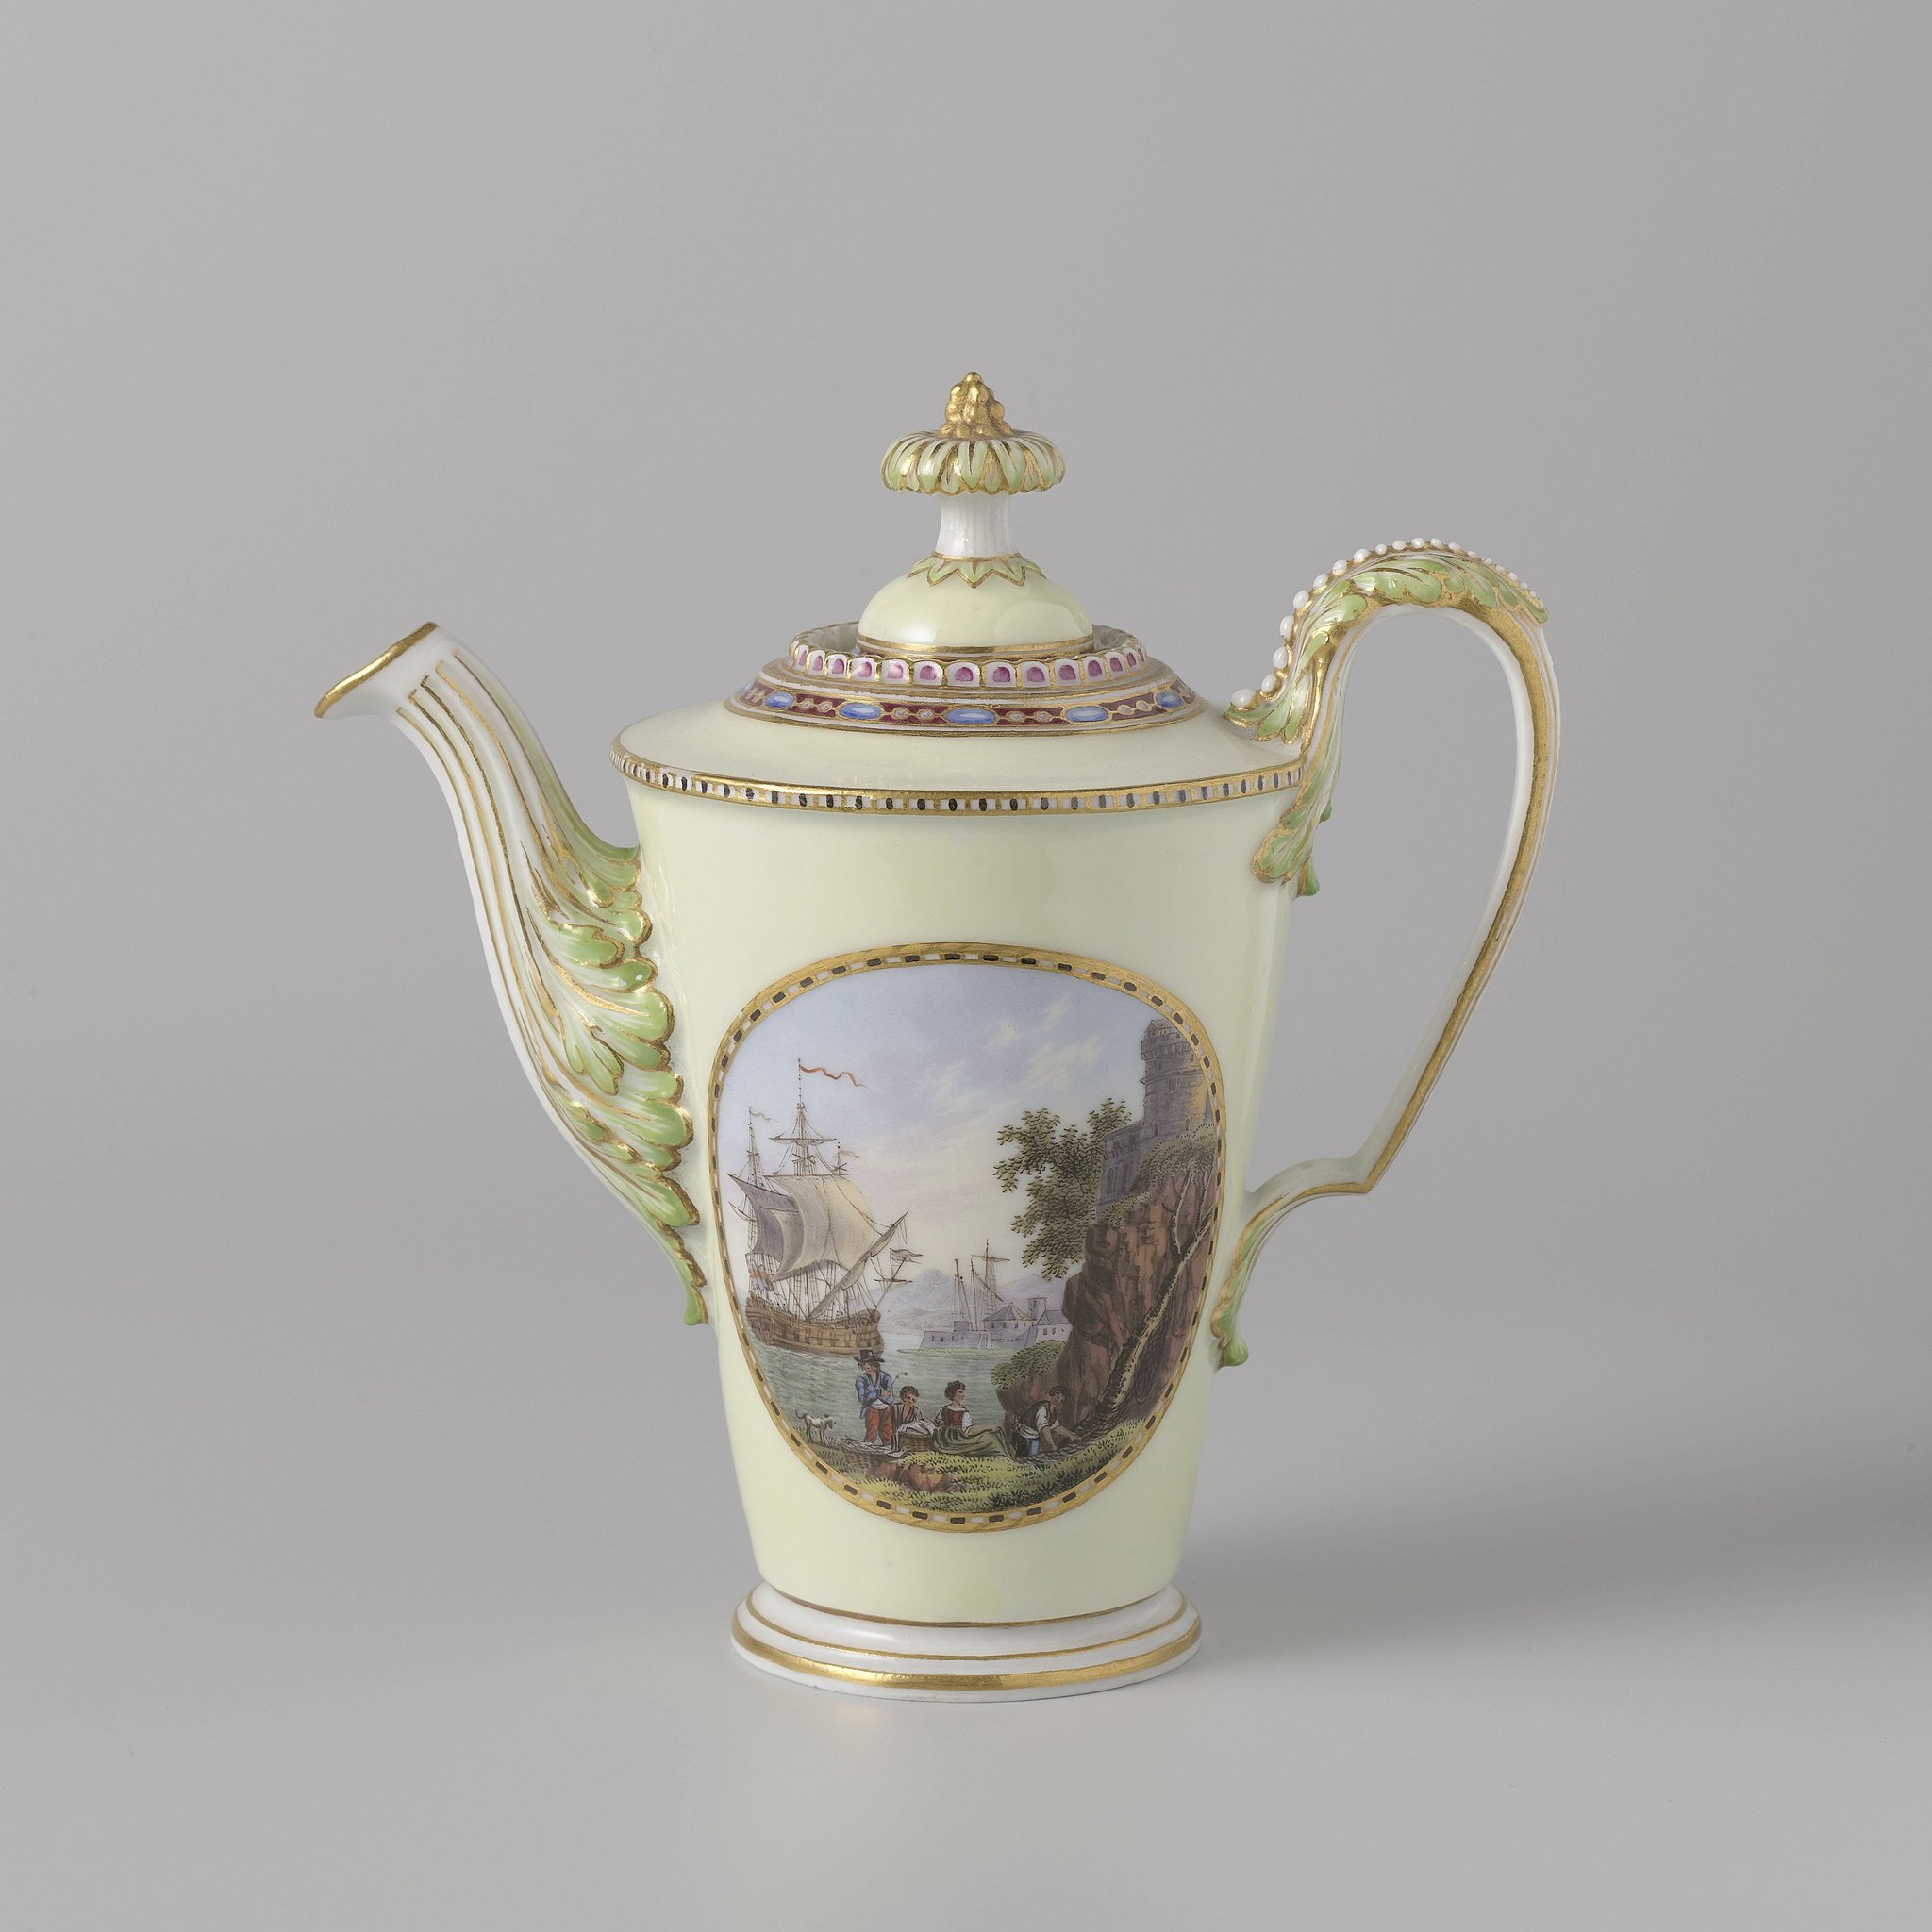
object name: milk jug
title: Melkkan met deksel, veelkleurig beschilderd met havengezichten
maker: johann gottlob karl liebezeit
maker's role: porseleinschilder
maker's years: 1766-1814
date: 1804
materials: porcelain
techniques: painted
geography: meissen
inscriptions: mold mark: ‘36 8’, painter's mark: ‘115’, factory mark, mark: ‘4’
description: Déjeuner (small tea or coffee set) with views of Mediterranean ports. On the tray a view ofthe harbour at Marseille. Porcelain. Meissen, dated 1804.